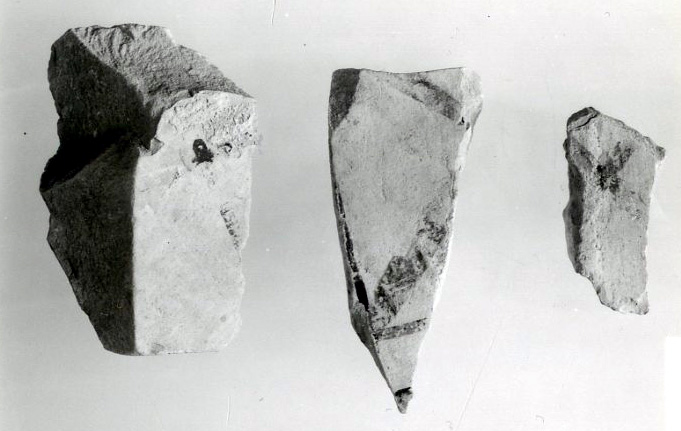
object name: relief fragment, tomb of meketre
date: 1981-1975 BCE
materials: limestone, paint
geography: egypt